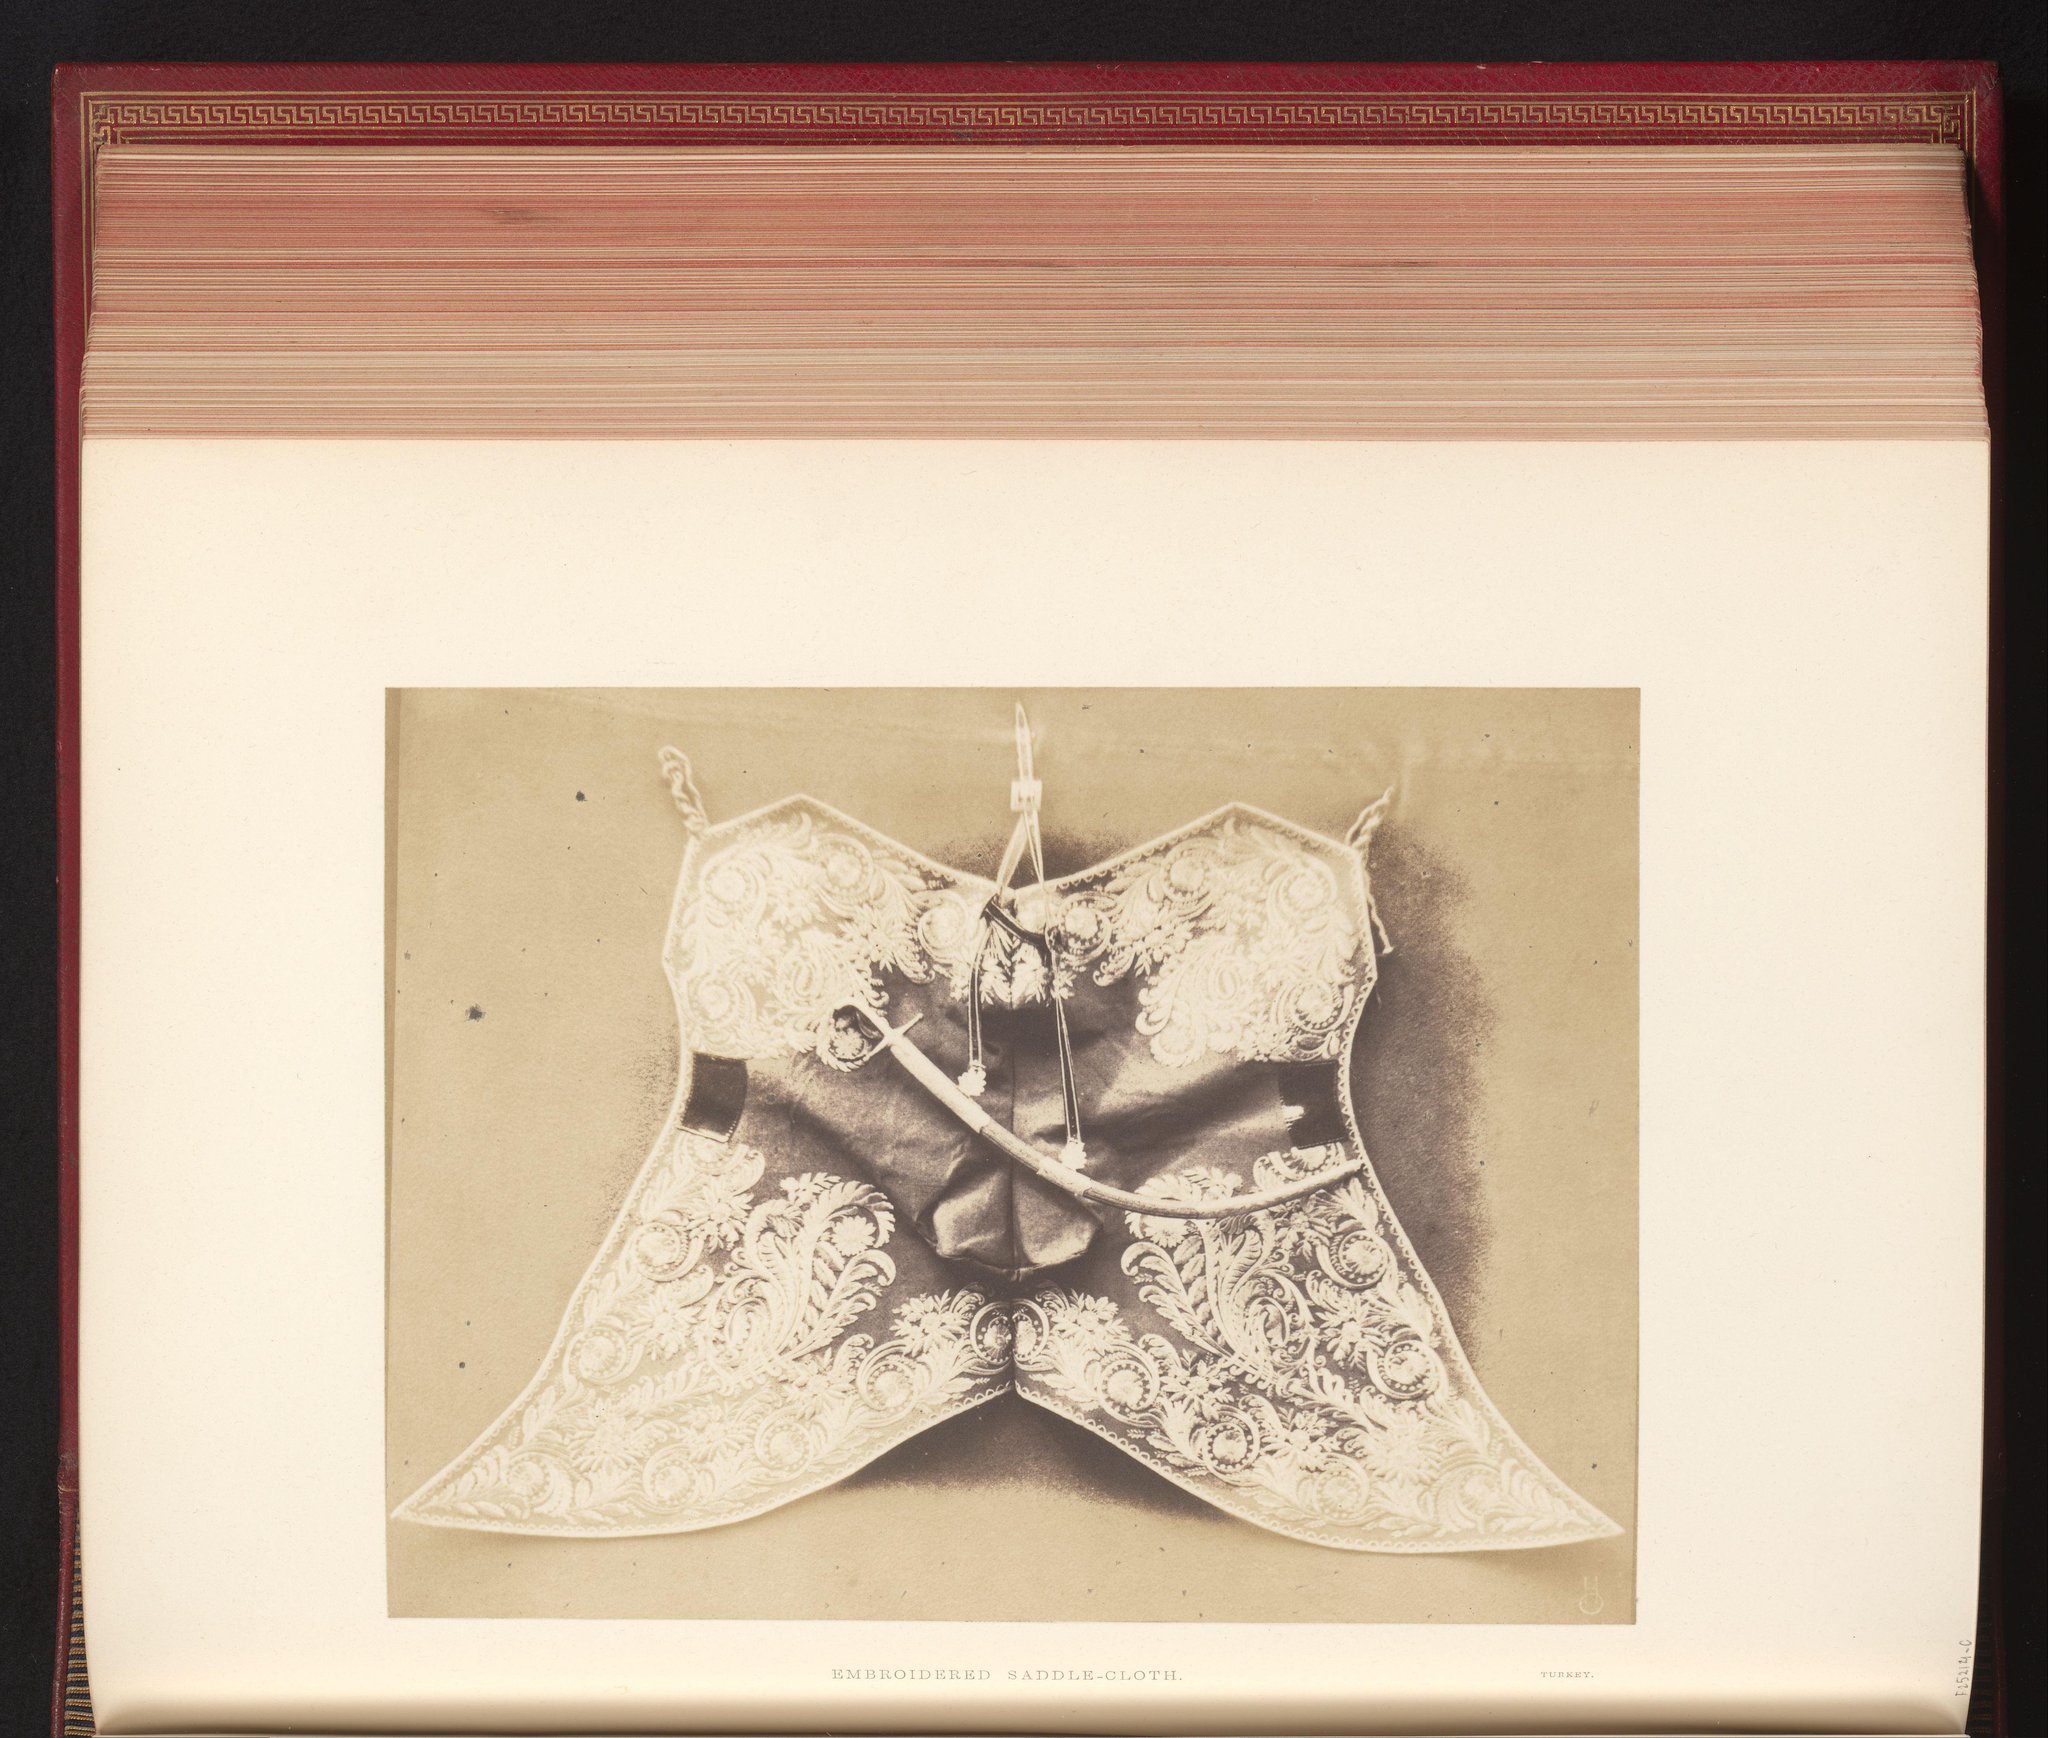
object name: page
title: Embroidered Saddle-Cloth. Turkey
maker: hugh owen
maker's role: fotograaf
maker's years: 1808-1897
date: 1851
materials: photographic support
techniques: salted paper print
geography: london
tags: saddle, london